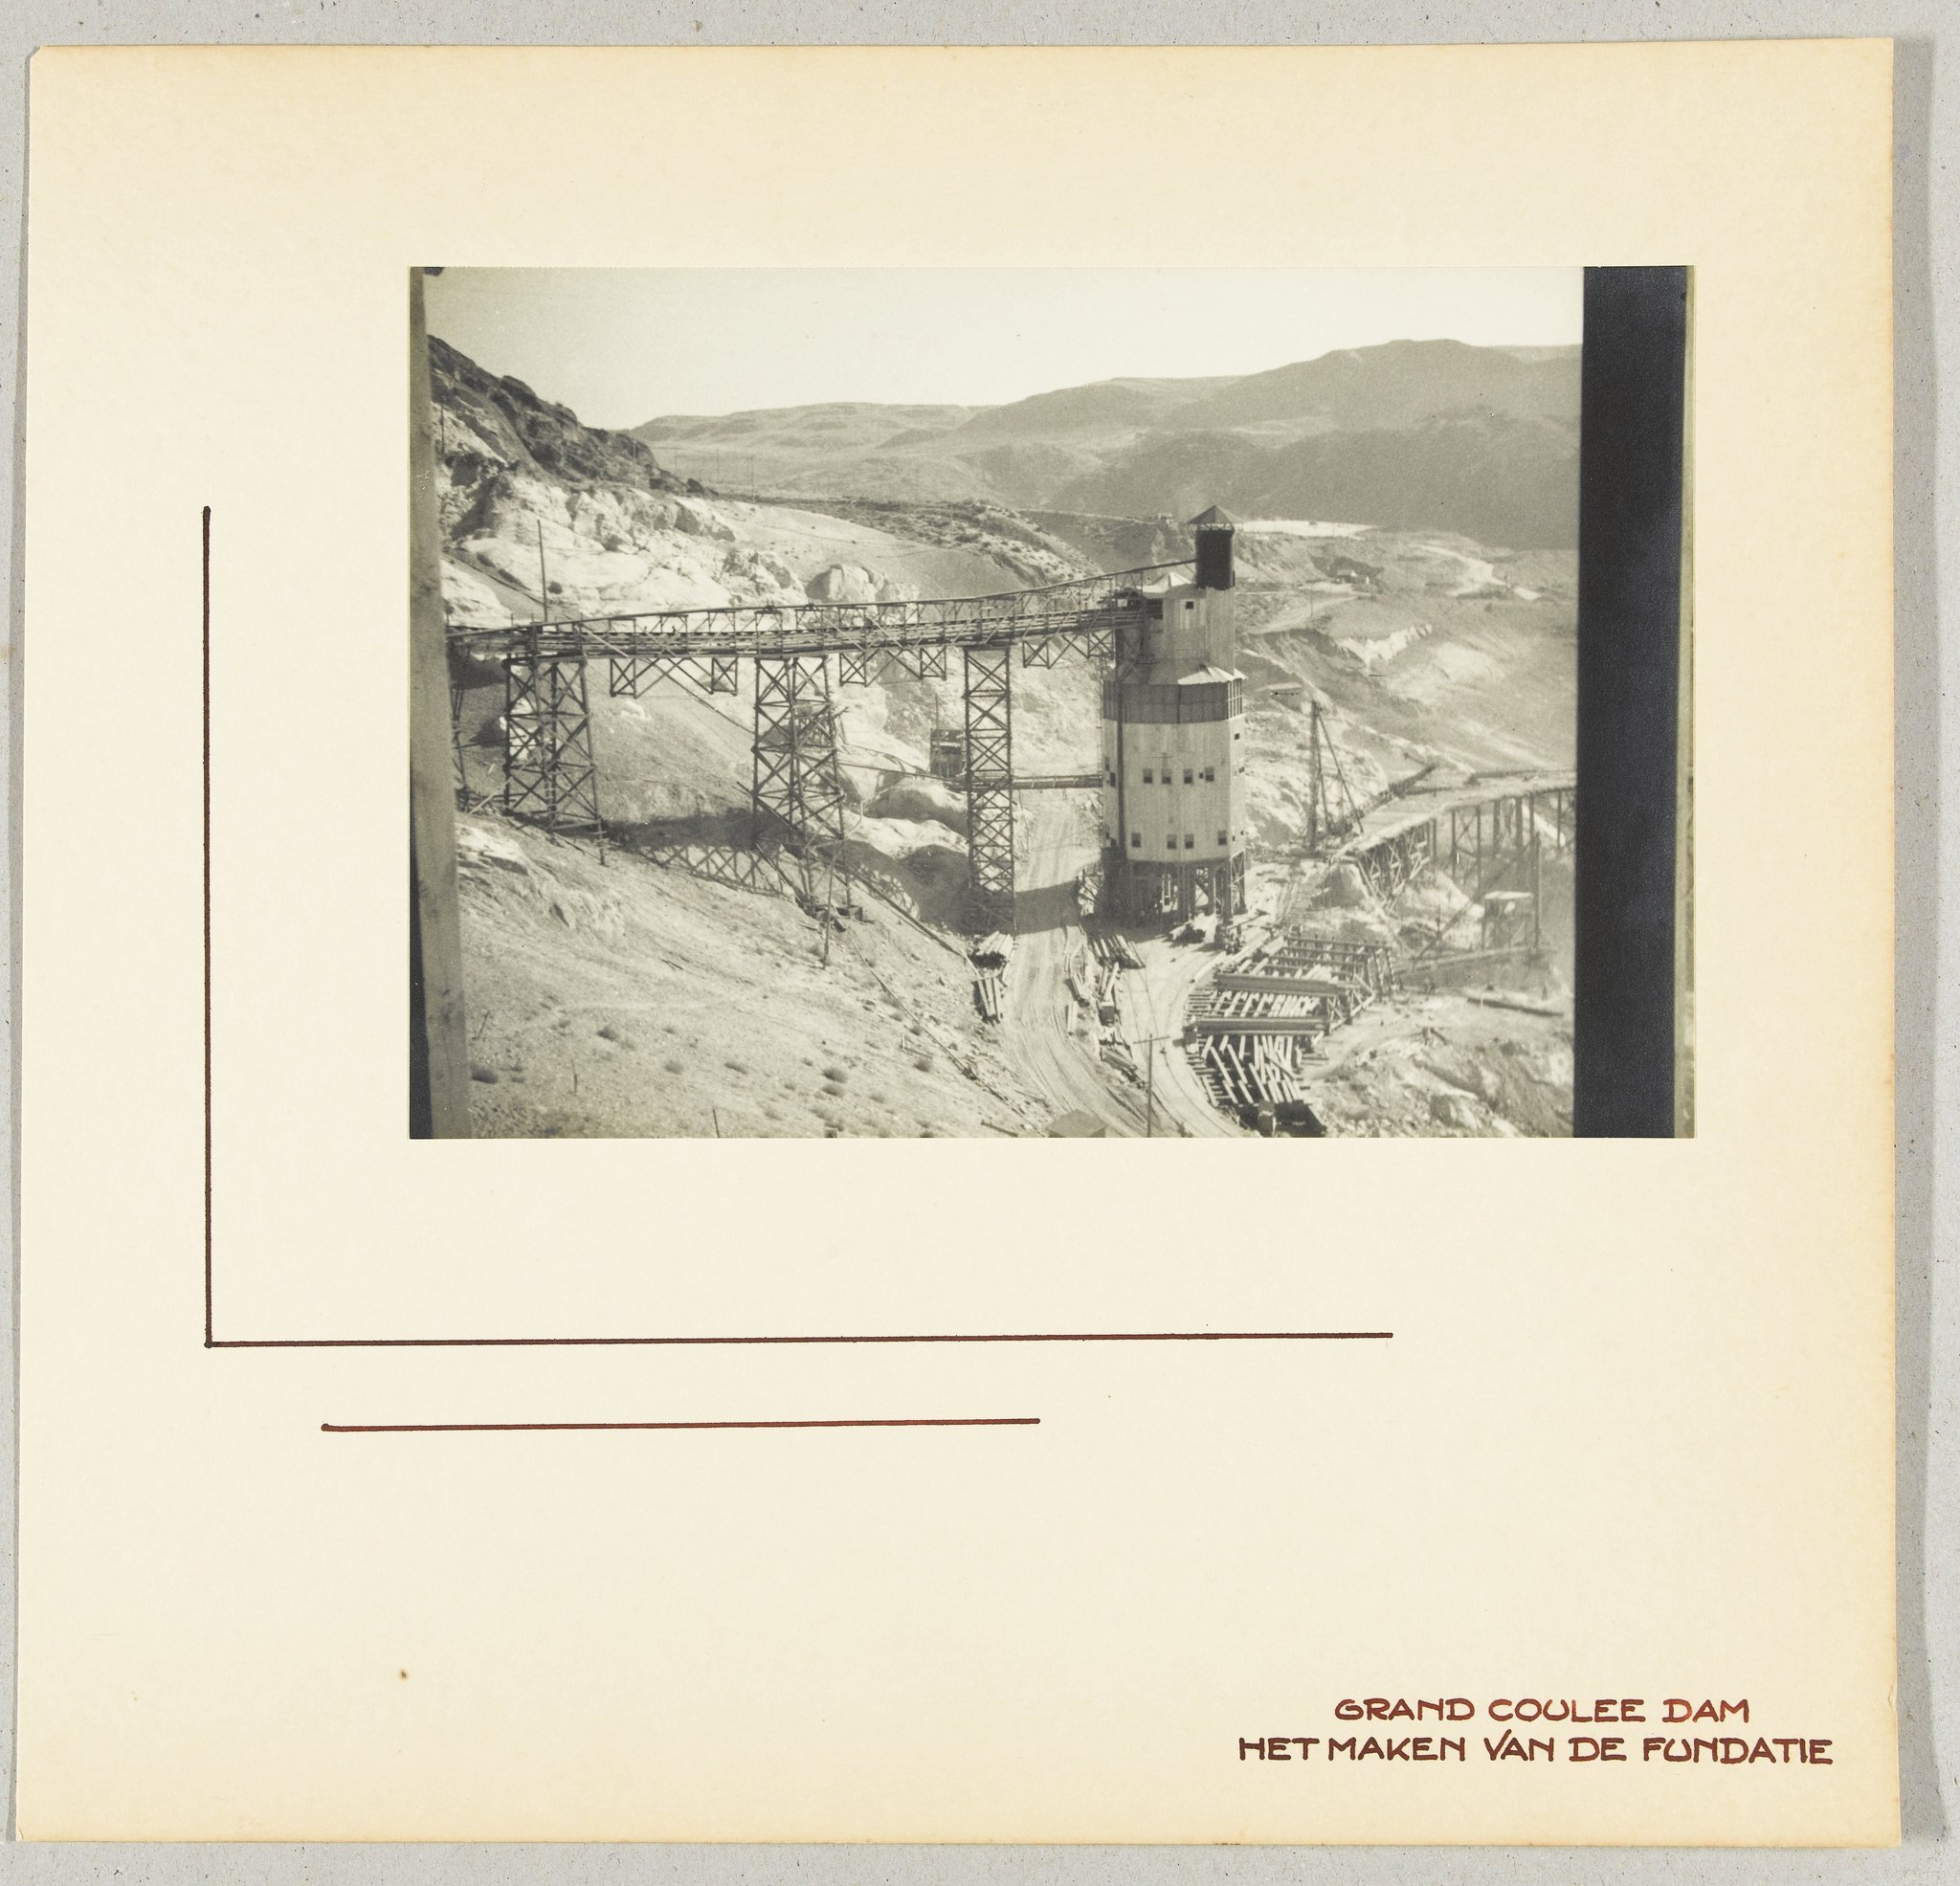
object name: photograph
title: Grand Coulee Dam, Columbia River, Verenigde Staten: bouwen van de fundering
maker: wouter cool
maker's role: engineer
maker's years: 1877-1947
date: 1936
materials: cardboard, paper, photographic support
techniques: gelatin silver print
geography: united states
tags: dam (in canal)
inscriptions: title: ‘GRAND COULEE DAM / HET MAKEN VAN DE FUNDATIE’